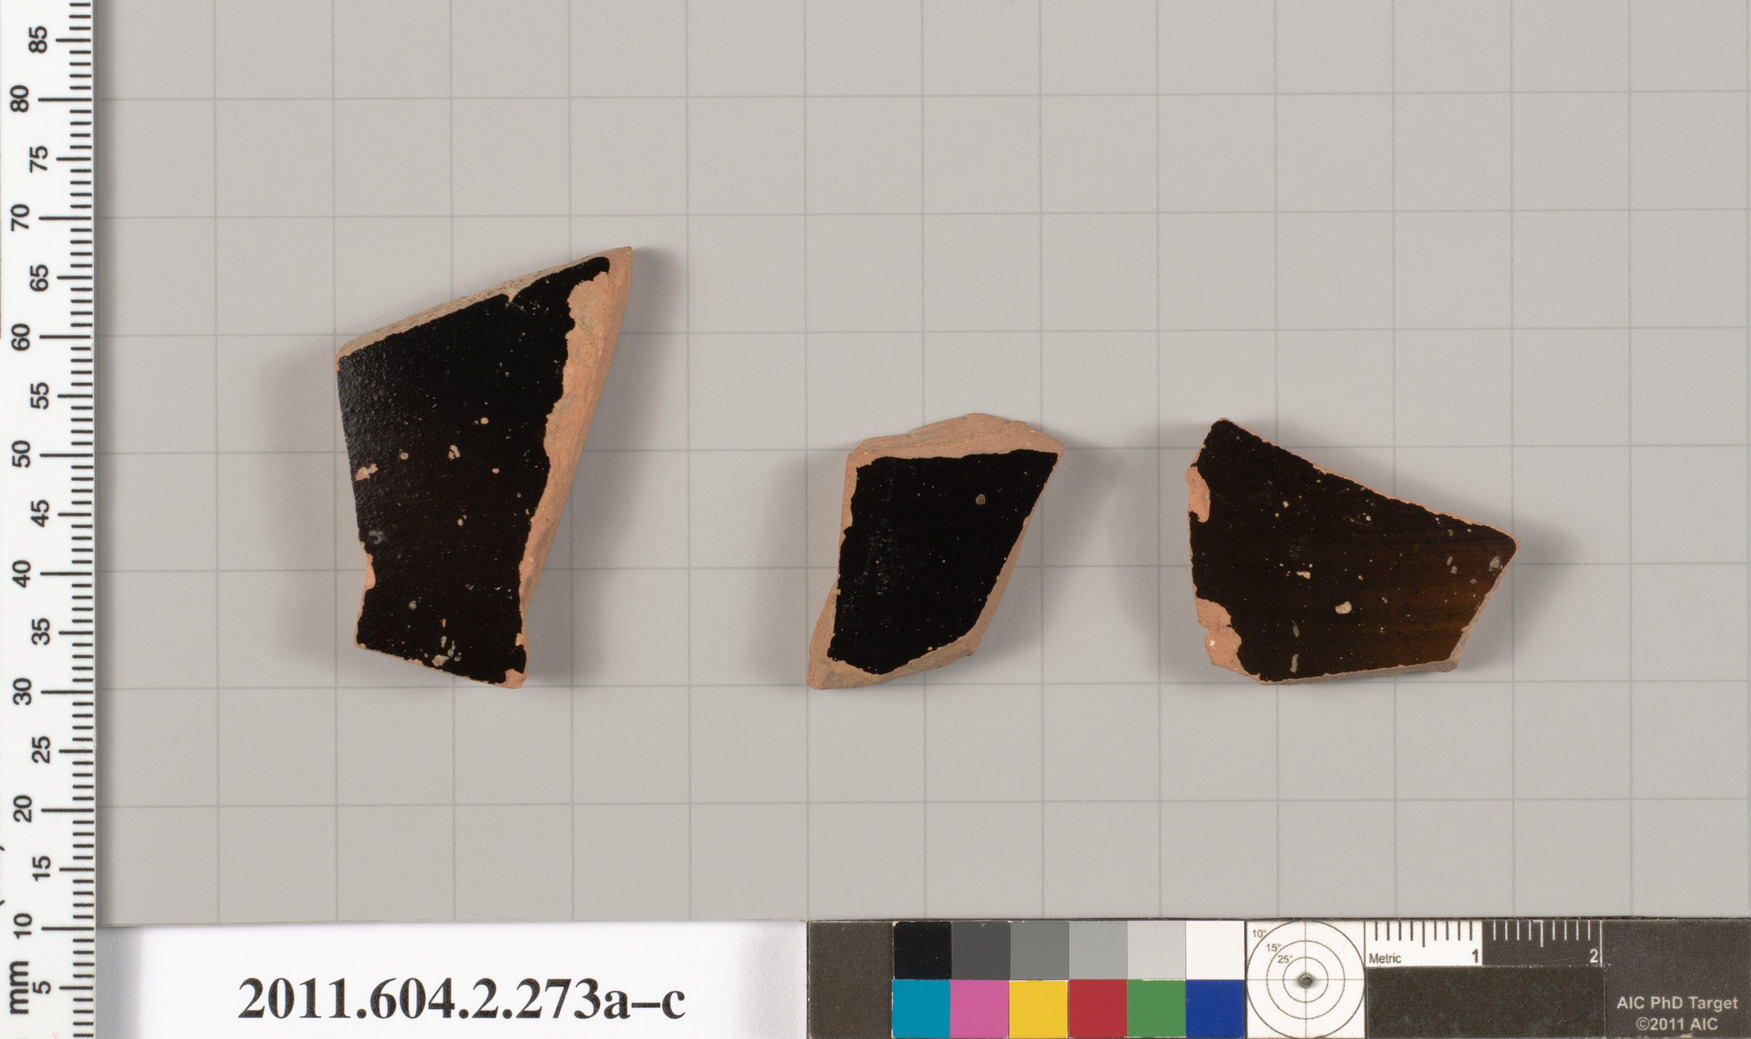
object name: stamnoi fragment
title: Terracotta fragments of stamnoi (jars)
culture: greek, attic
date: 600-401 BCE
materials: terracotta